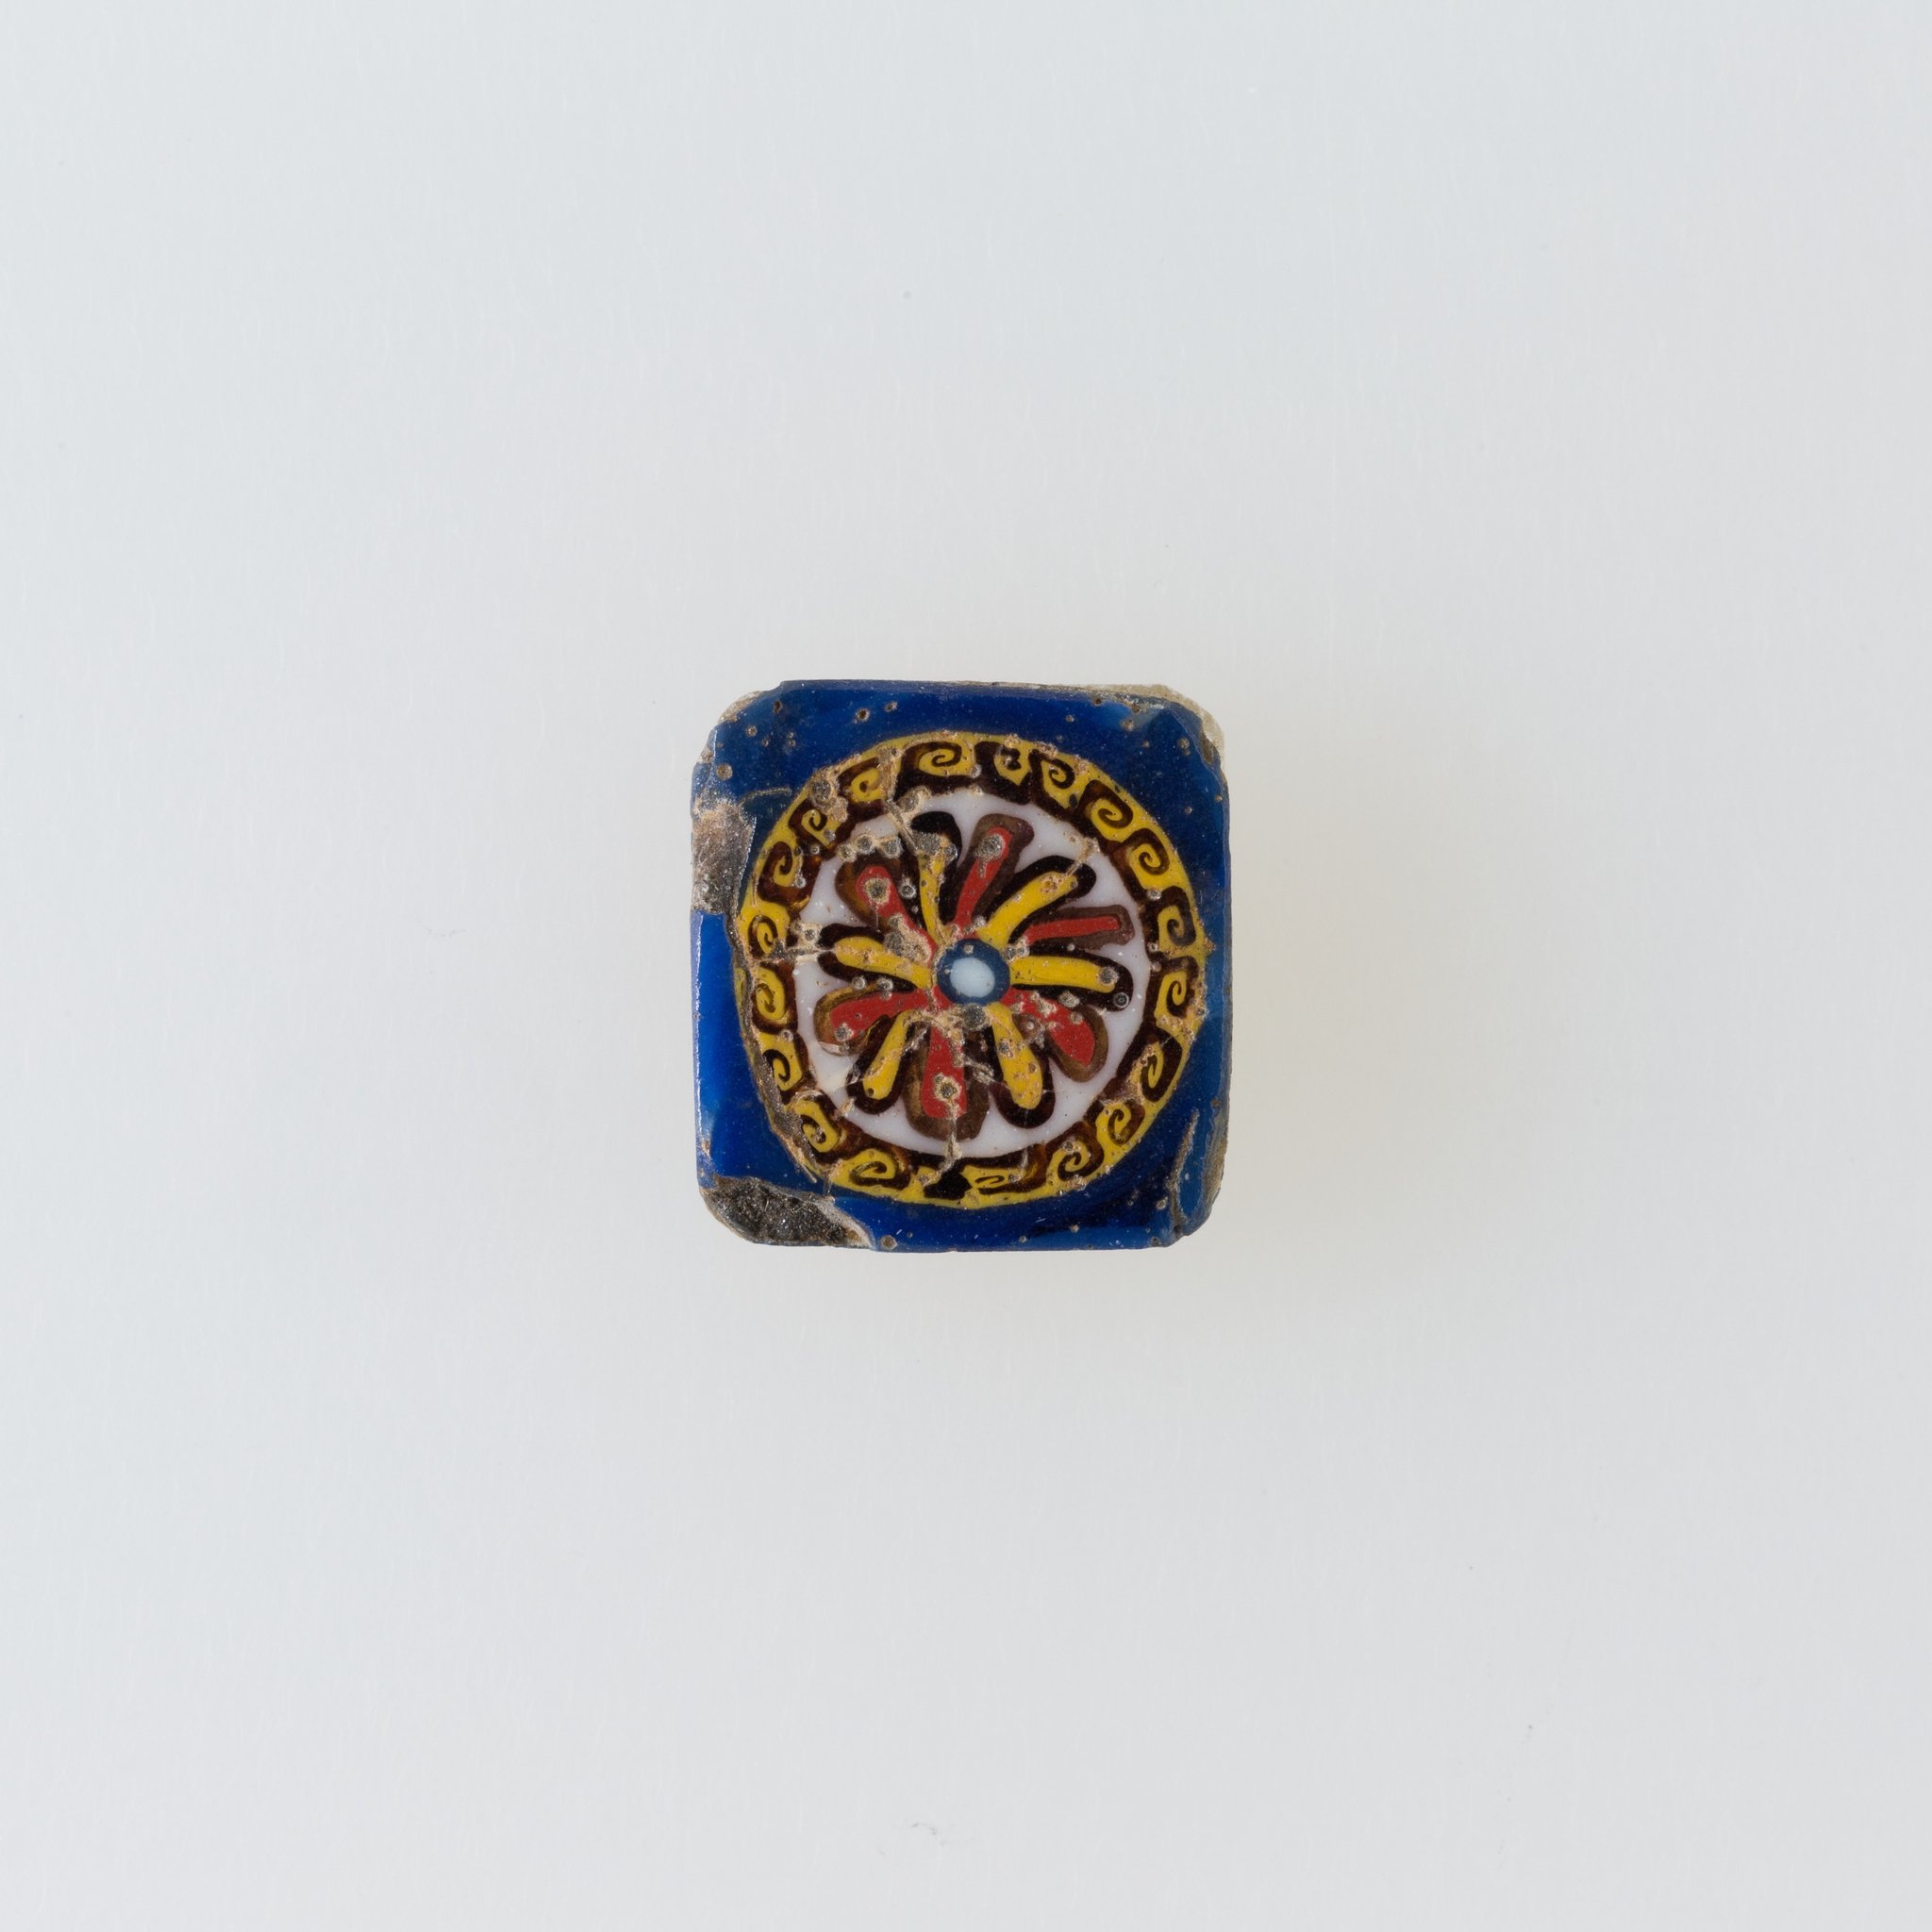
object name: inlay, rosette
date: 100 BCE-100 CE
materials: glass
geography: egypt